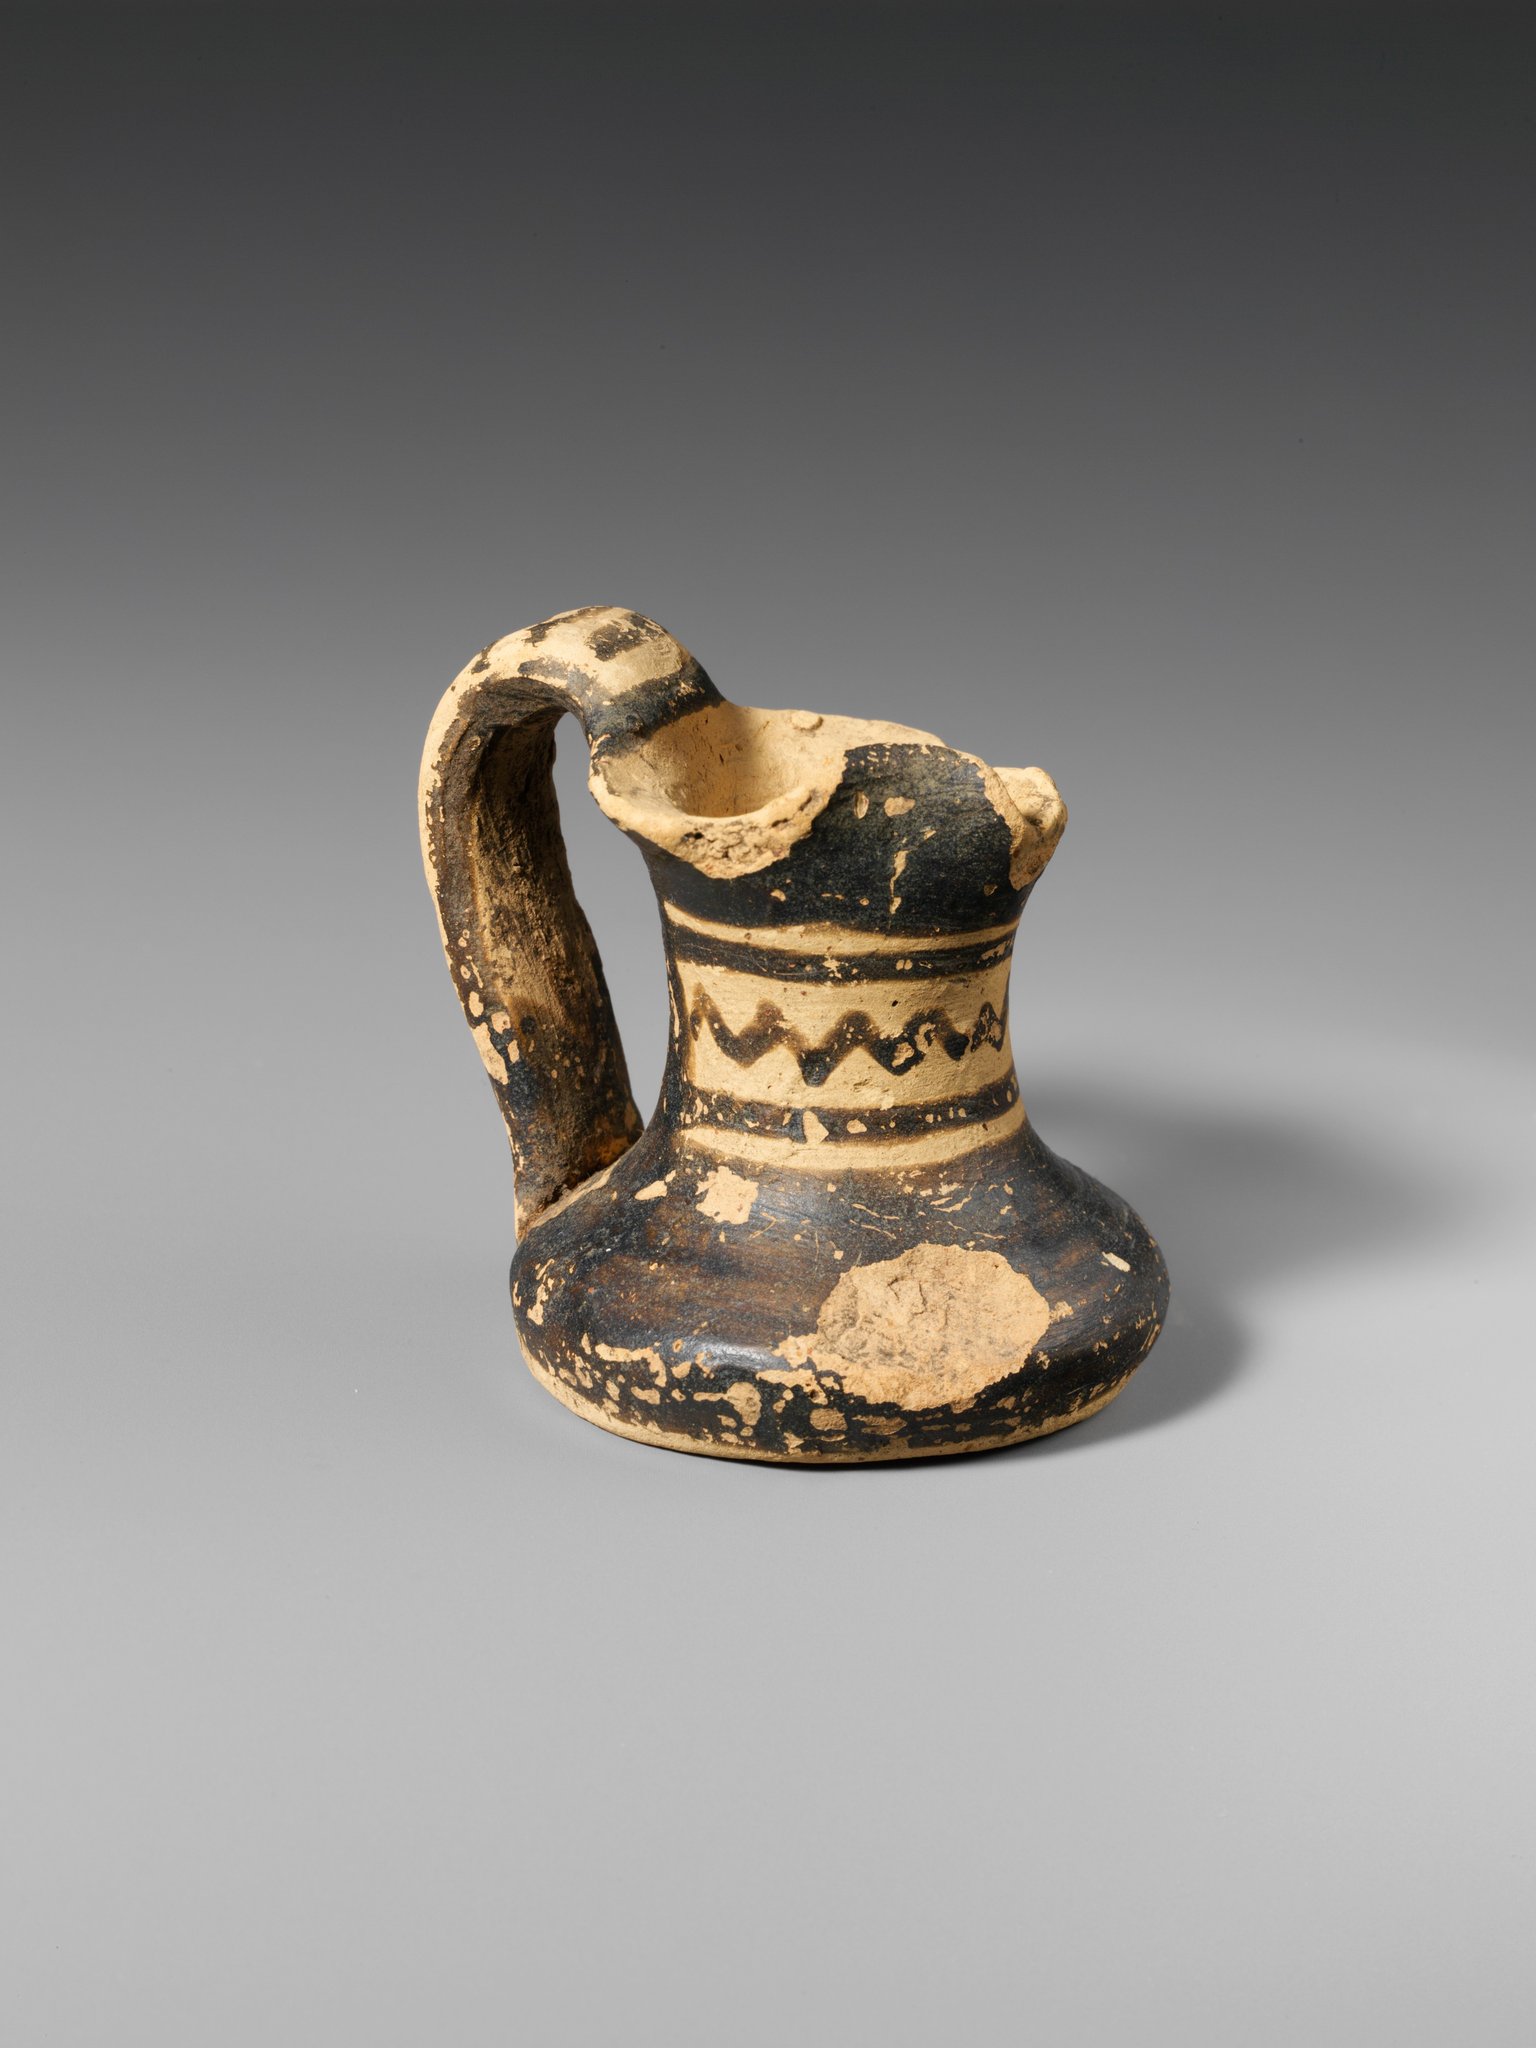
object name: jug, miniature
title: Miniature terracotta jug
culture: greek, attic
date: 834-801 BCE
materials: terracotta